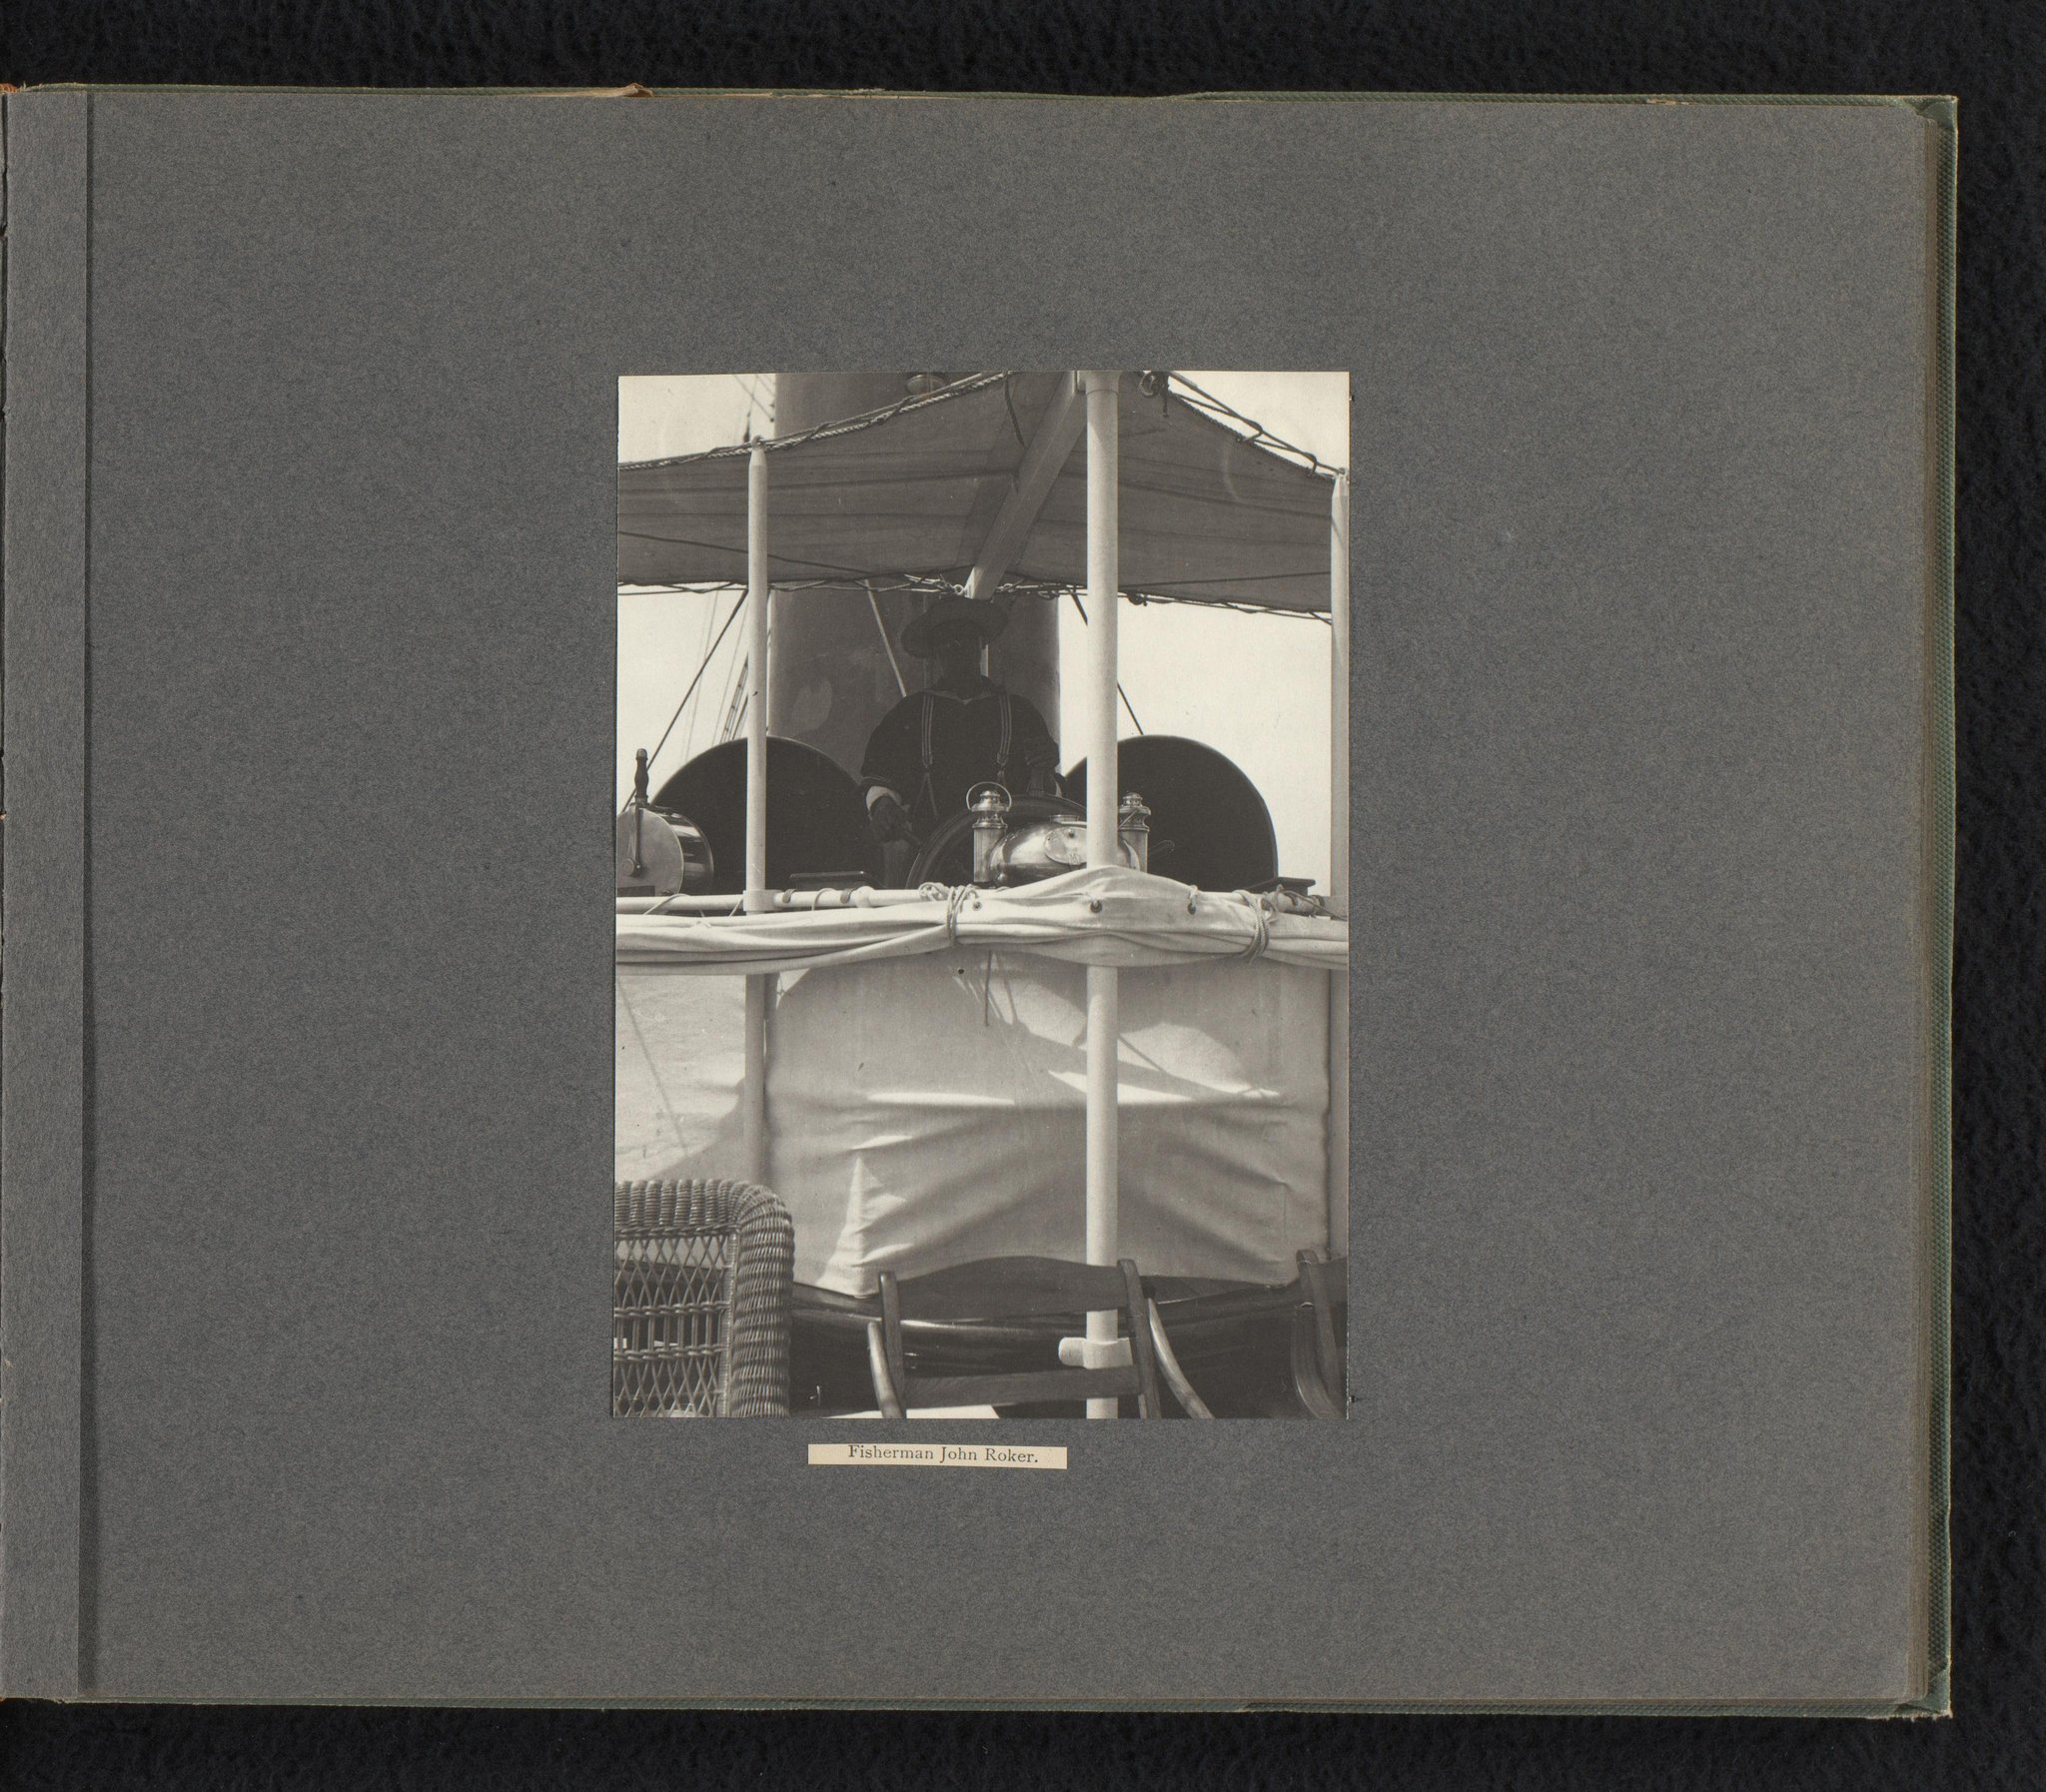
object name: album leaf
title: Fisherman John Roker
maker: Anonymous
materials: paper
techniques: platinum process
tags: manoeuvering a ship